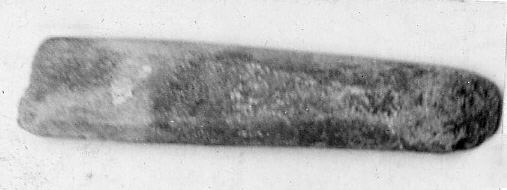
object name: pestle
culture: japanese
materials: stone